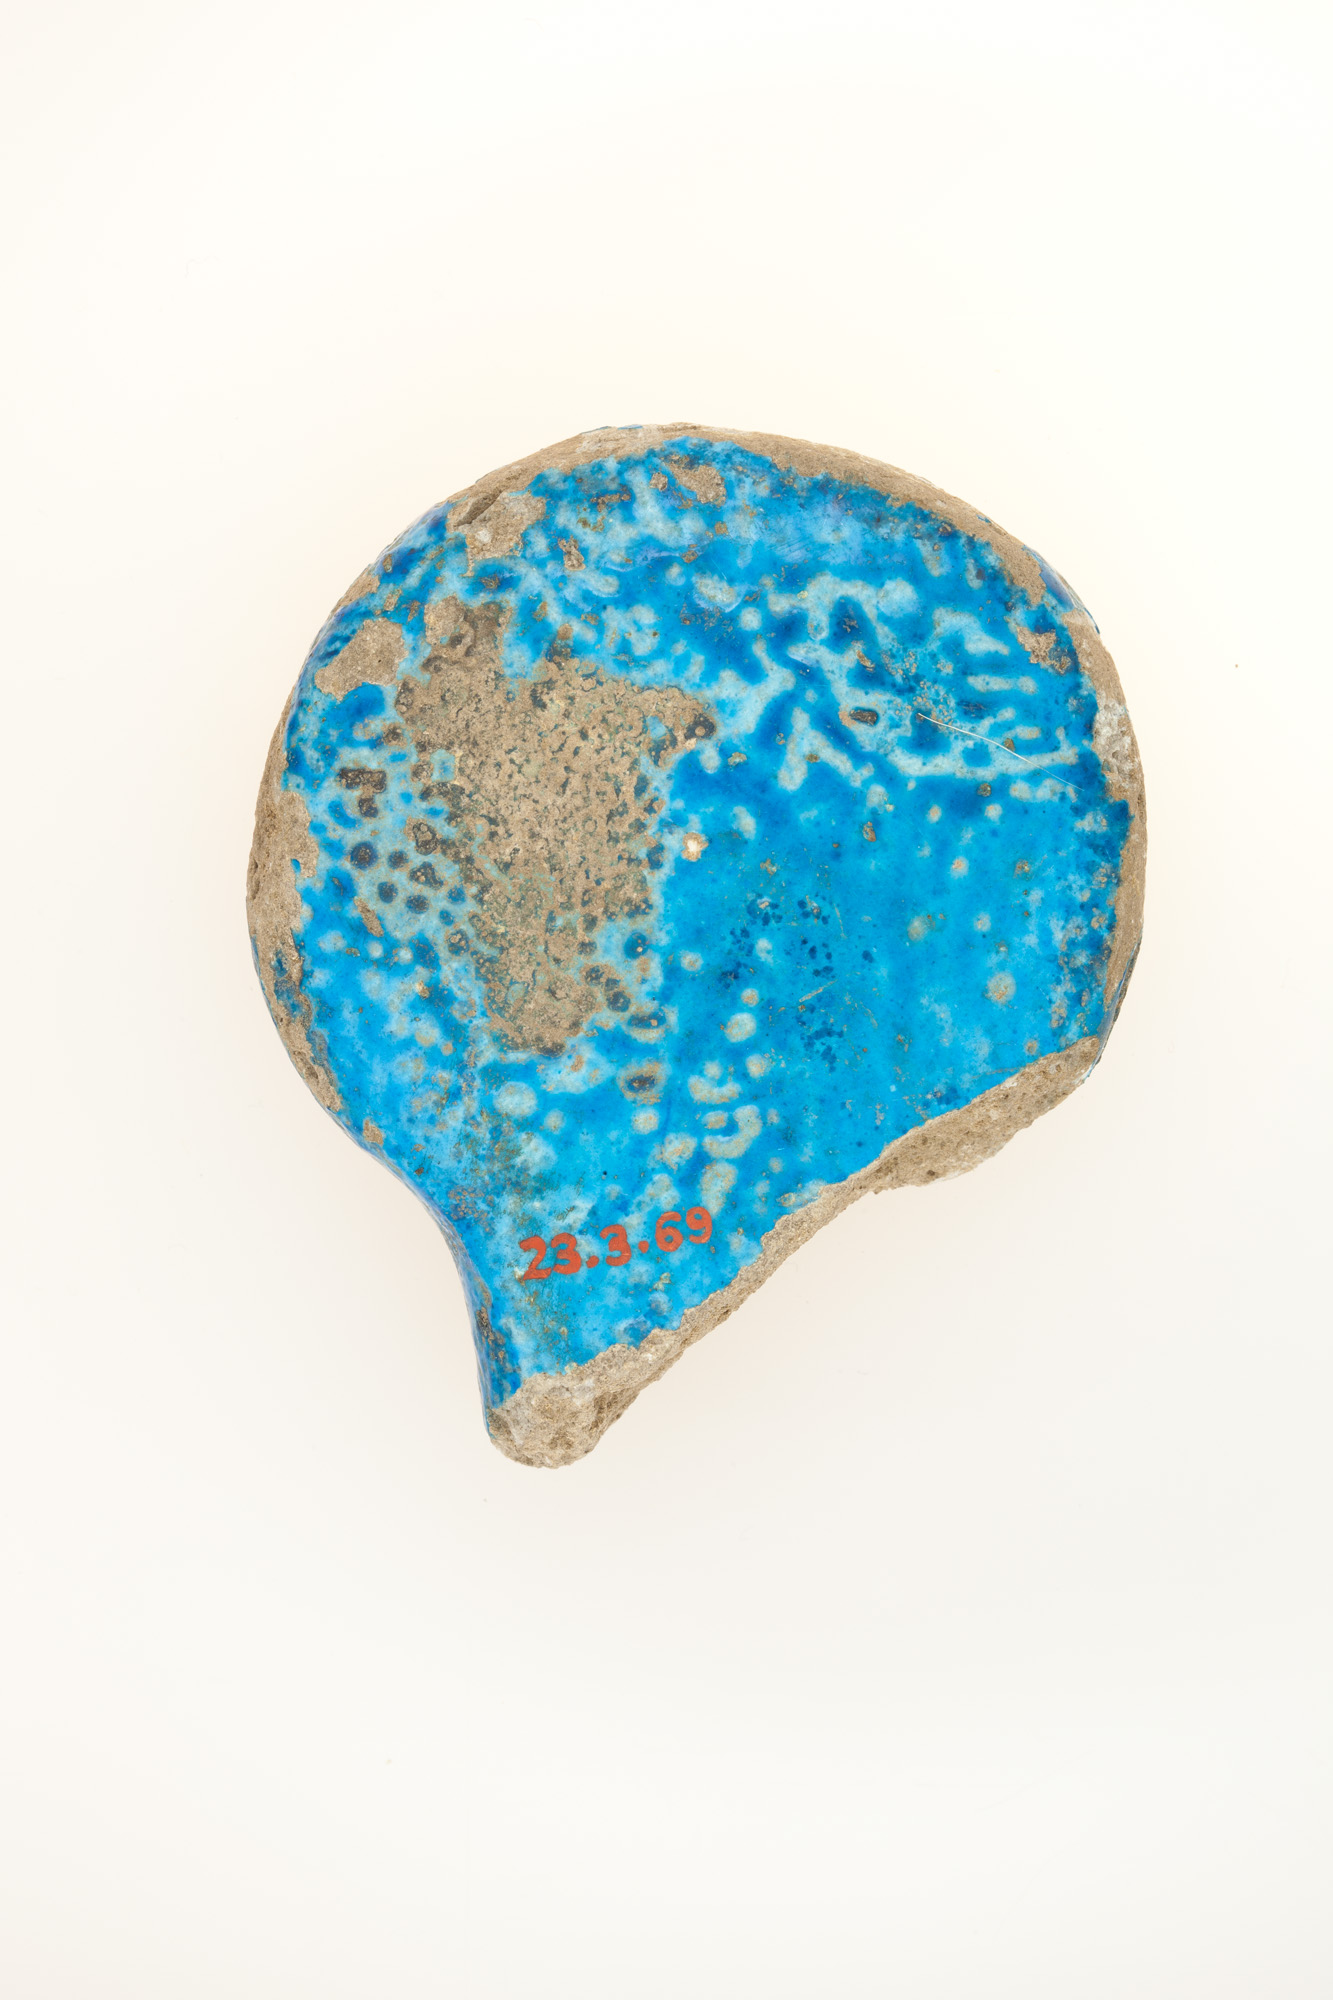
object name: menat fragment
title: Votive Menat fragments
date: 1479-1458 BCE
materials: faience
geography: egypt